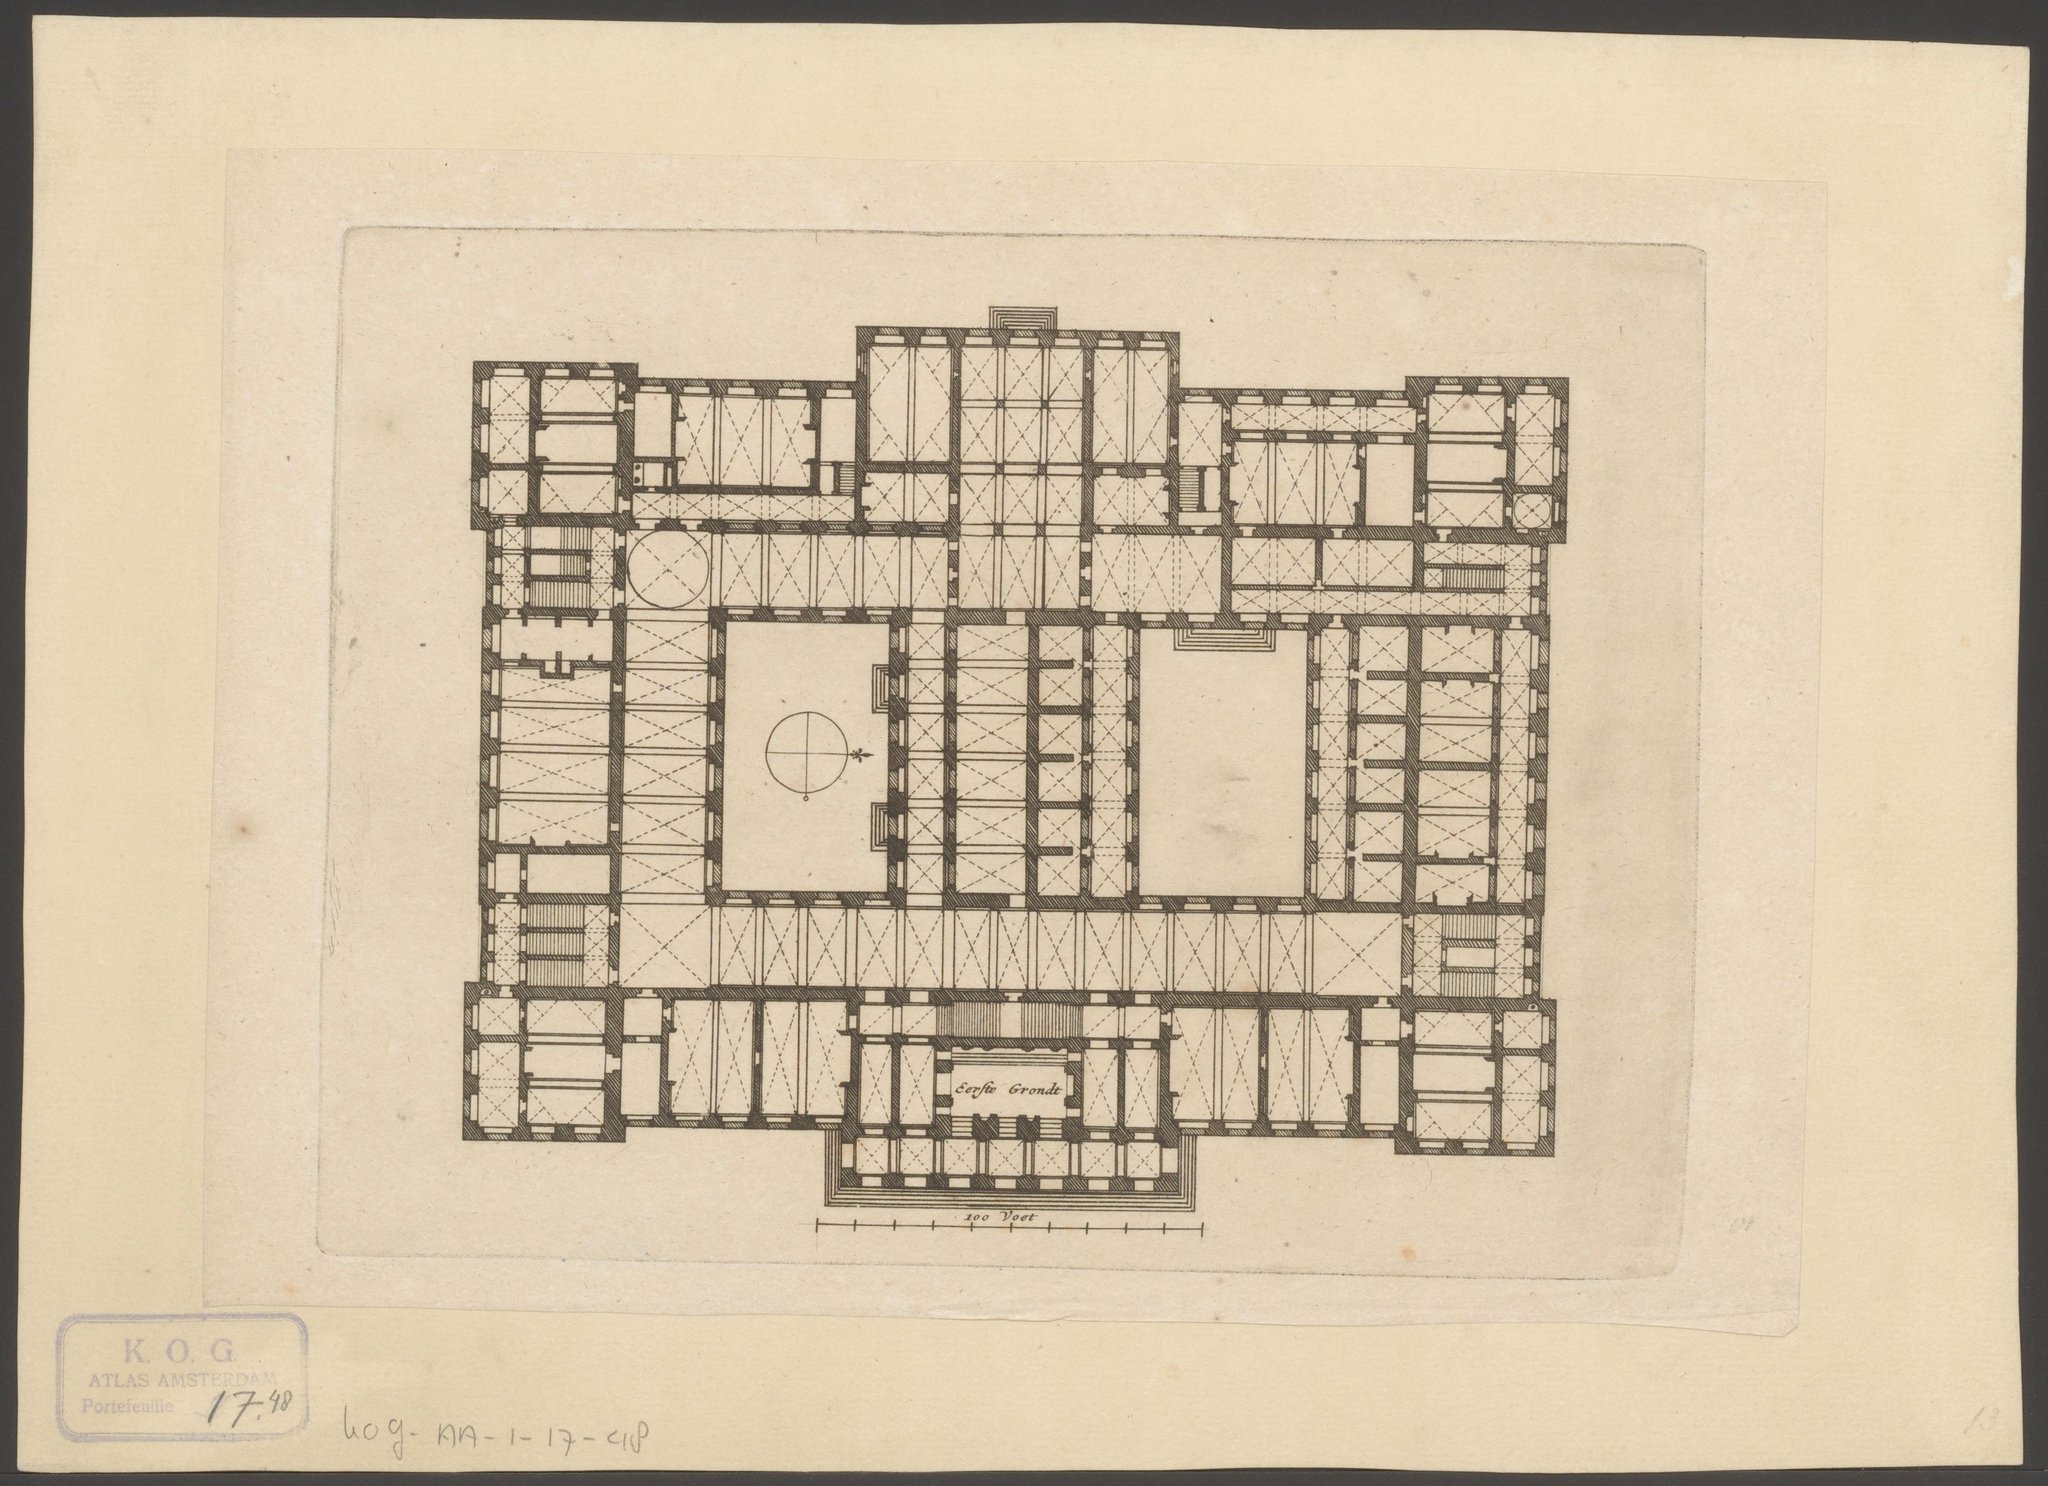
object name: print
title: Plattegrond van de begane grond (eerste grondt) van het Stadhuis op de Dam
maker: Anonymous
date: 1650-1750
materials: paper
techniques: etching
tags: townhall, plan ~ architecture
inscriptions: collector's mark: ‘17.48’ Lugt 1641b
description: Onderwerpsrubriek binnen de Atlas Amsterdam: Nieuwe Stadhuis, van binnen: Kap, Plattegronden, Betimmering.